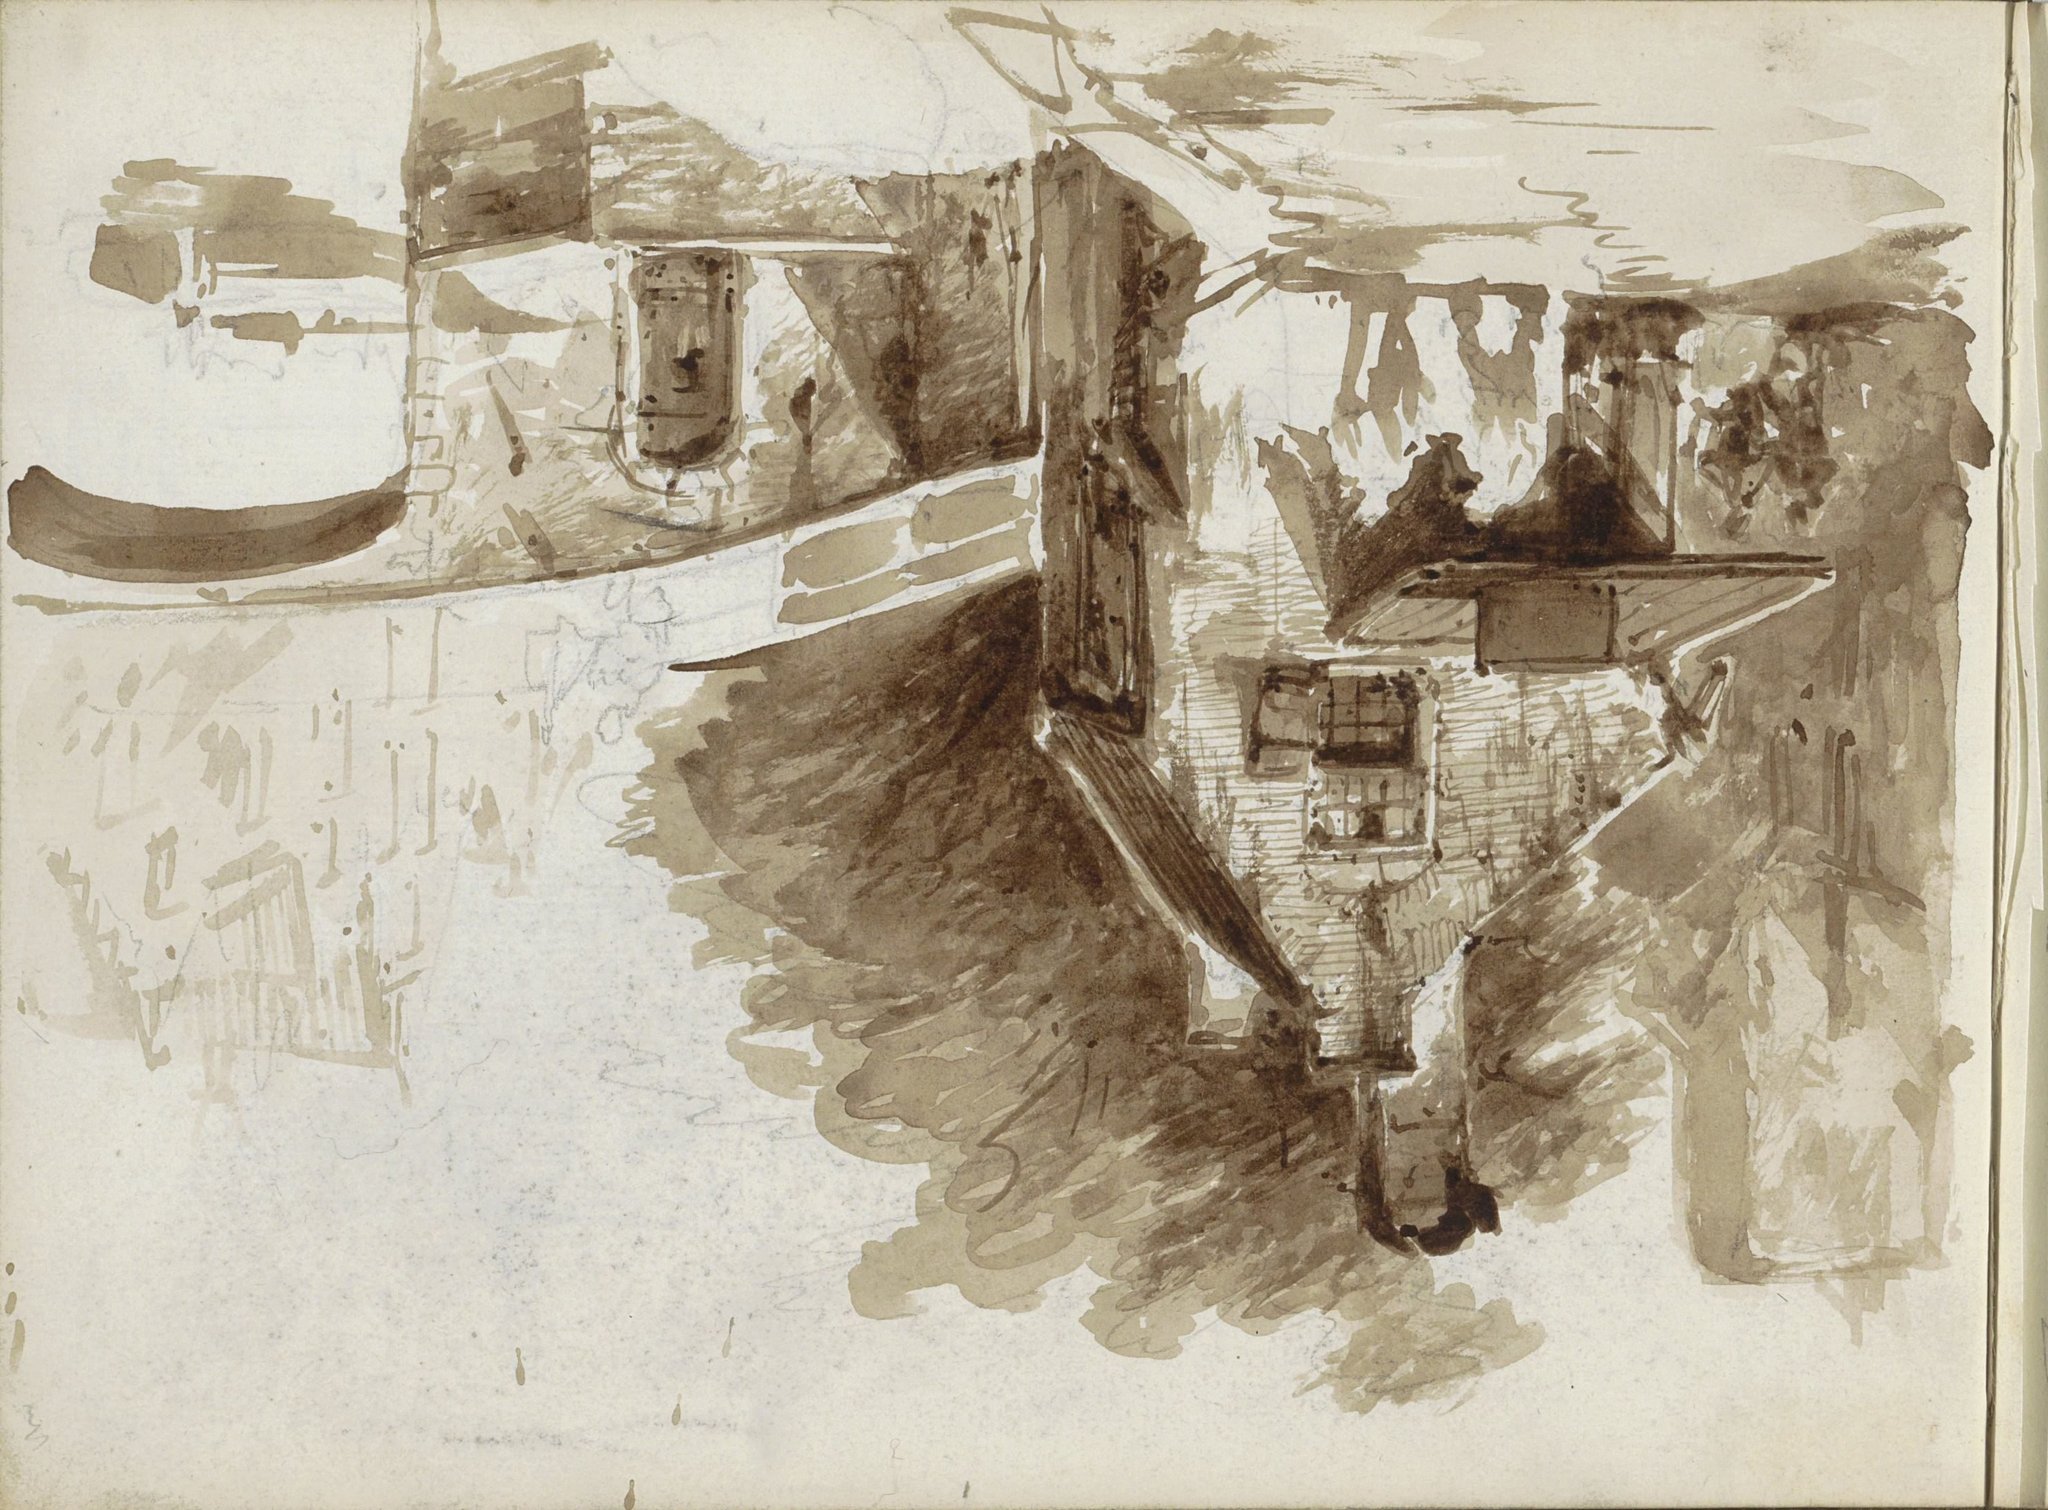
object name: sketchbook leaf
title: Huis naast een brug over een gracht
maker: willem koekkoek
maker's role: draughtsman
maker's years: 1839-1895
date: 1849-1895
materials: paper, pencil, watercolor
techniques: brush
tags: canals, waters (in city), the usual house or row of houses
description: Op de achtergrond een rij huizen. Pagina 13 verso uit een schetsboek met 26 bladen.